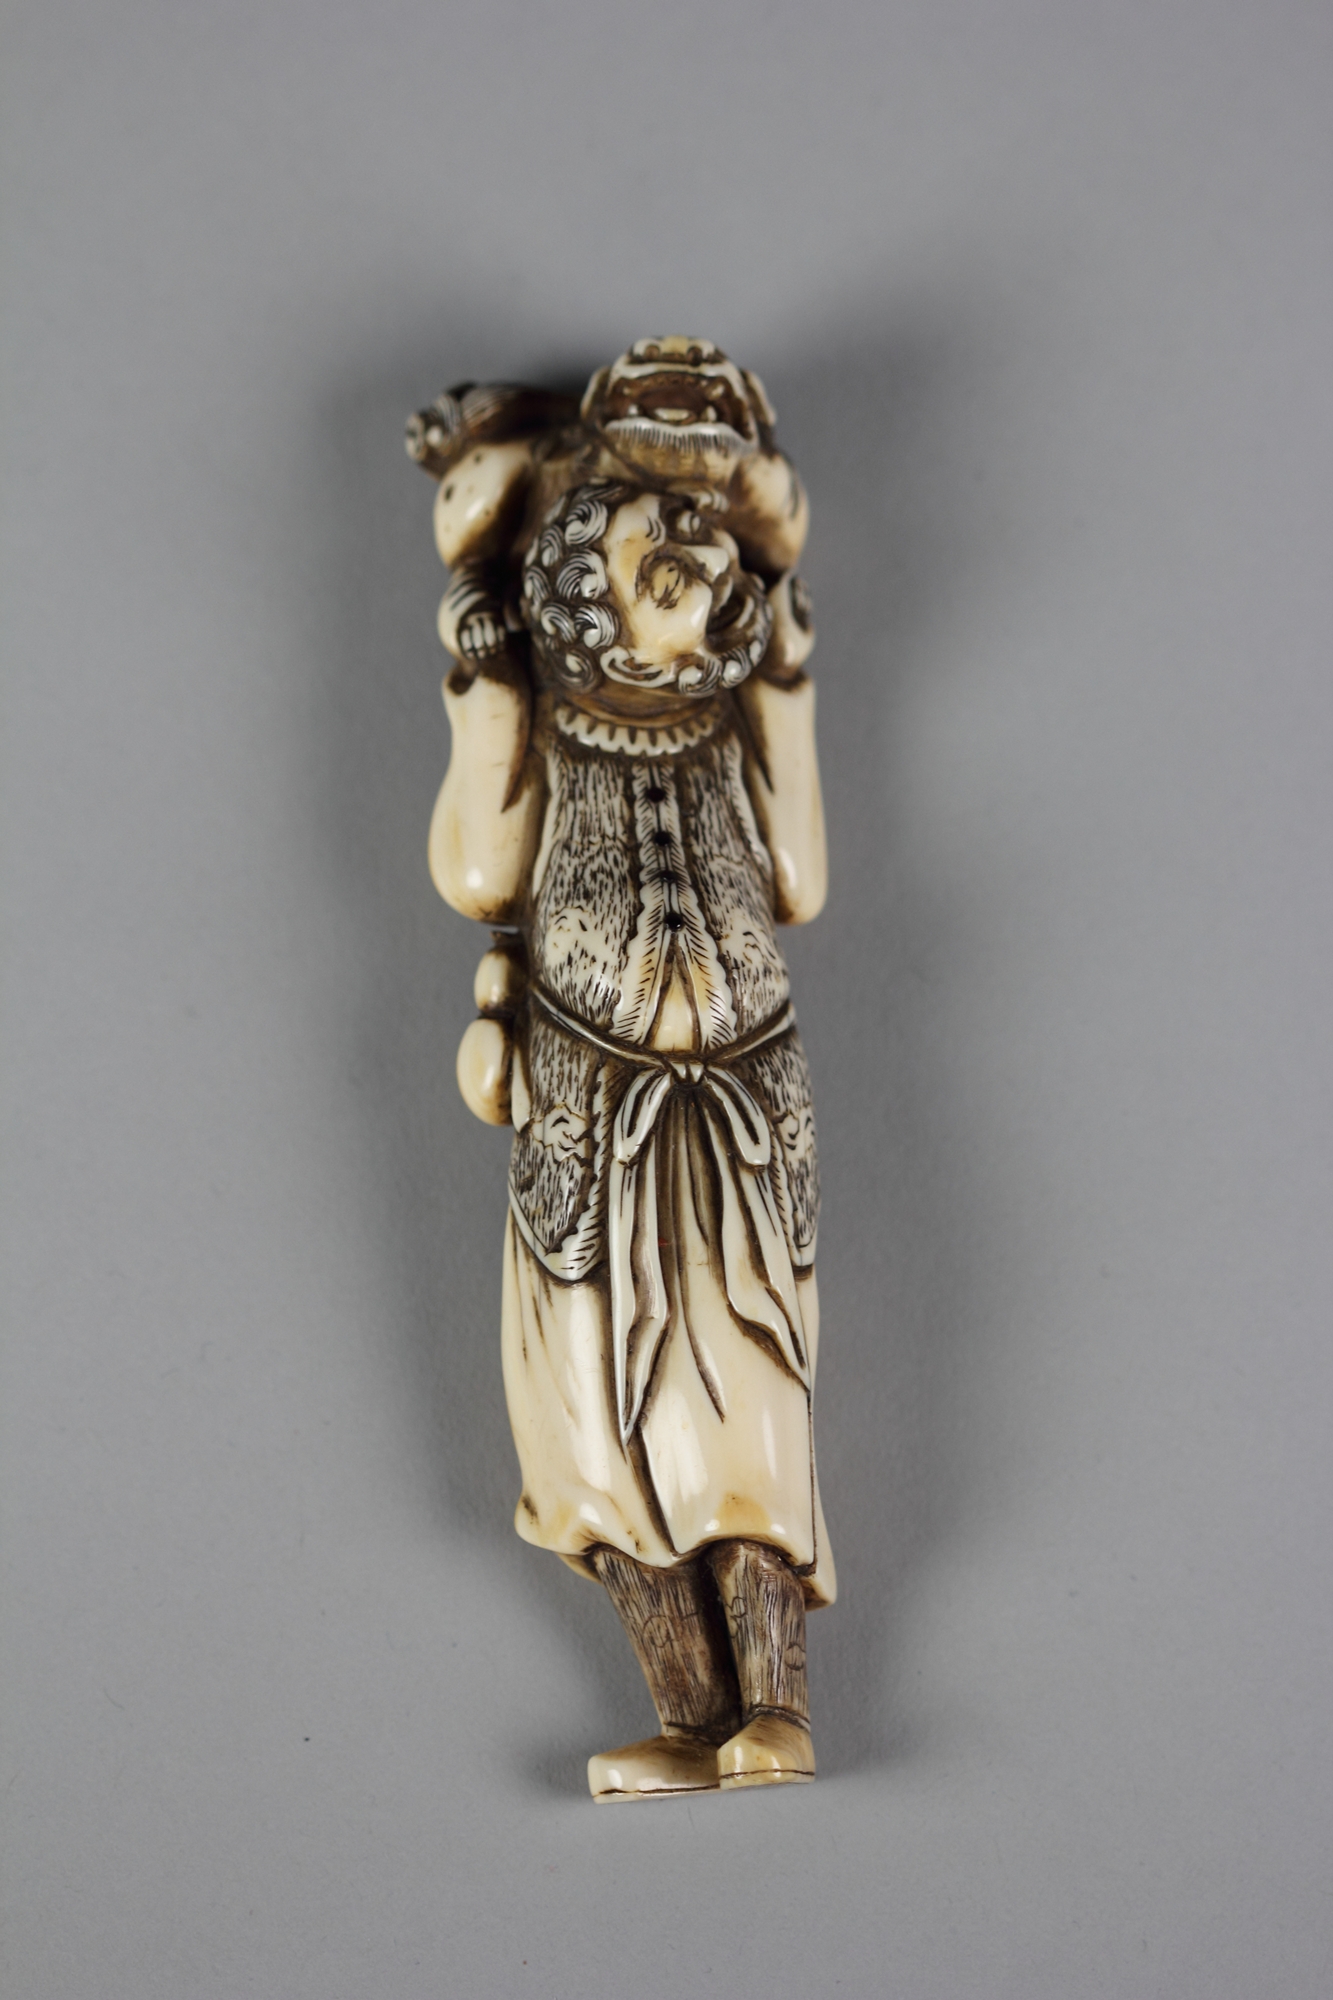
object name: netsuke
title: Netsuke of Sennin with Karashishi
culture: japanese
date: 1701-1800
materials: ivory